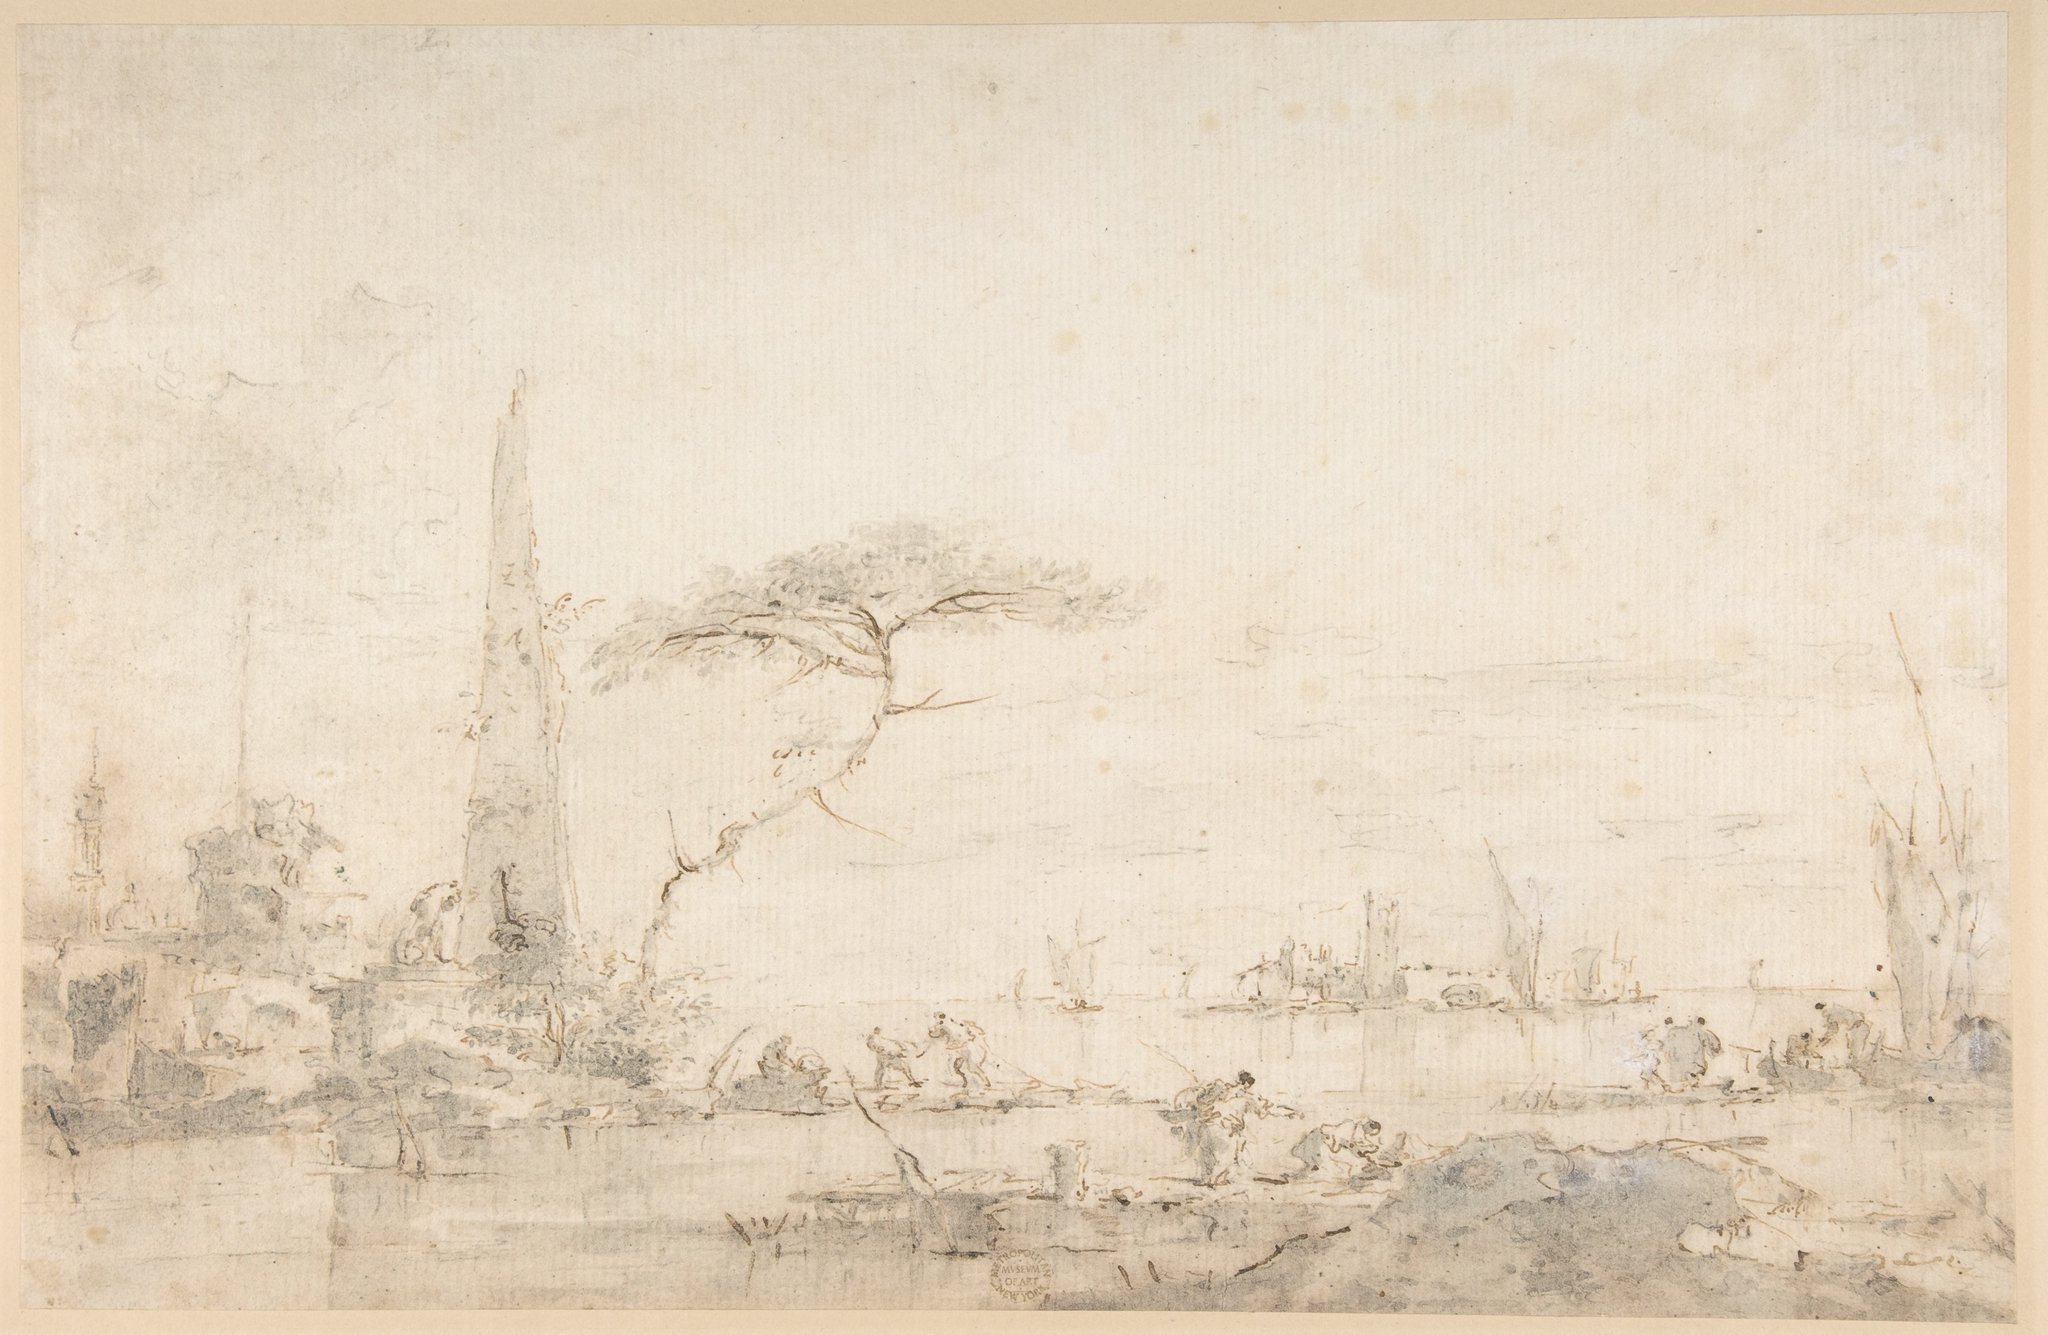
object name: drawing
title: Lagoon Capriccio with an Obelisk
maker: francesco guardi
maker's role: artist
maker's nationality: italian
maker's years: 1712-1793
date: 1750-1770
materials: chalk, ink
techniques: brush, pen, wash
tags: human figures,obelisks,landscapes,trees